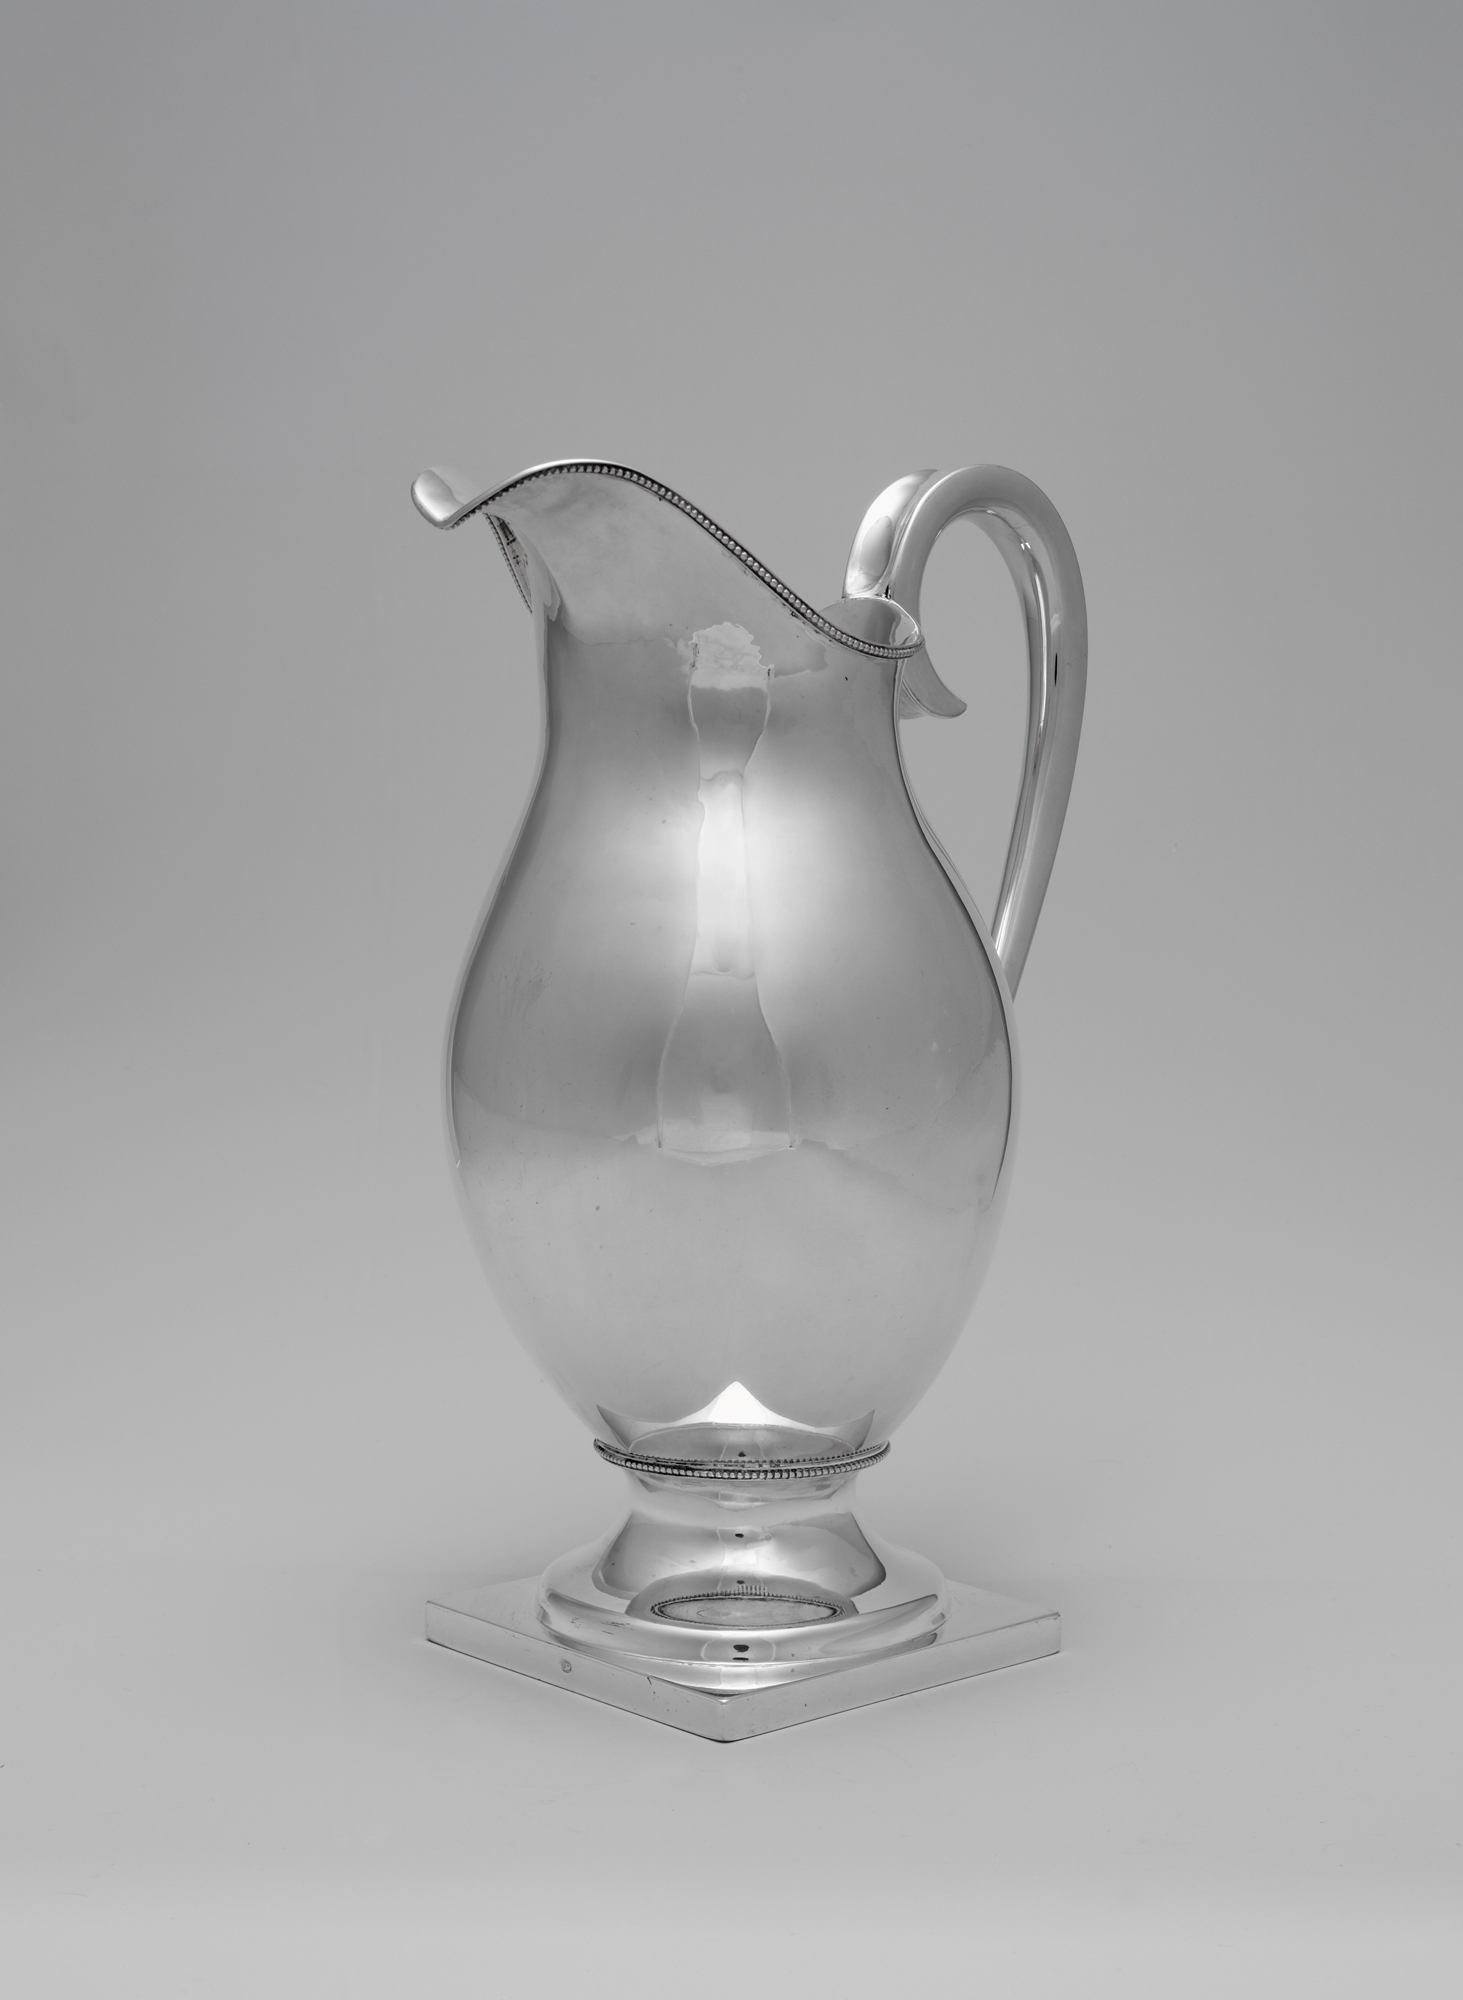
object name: pitcher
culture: american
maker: isaac hutton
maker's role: maker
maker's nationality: american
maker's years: 1766-1855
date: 1790-1817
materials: silver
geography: united states